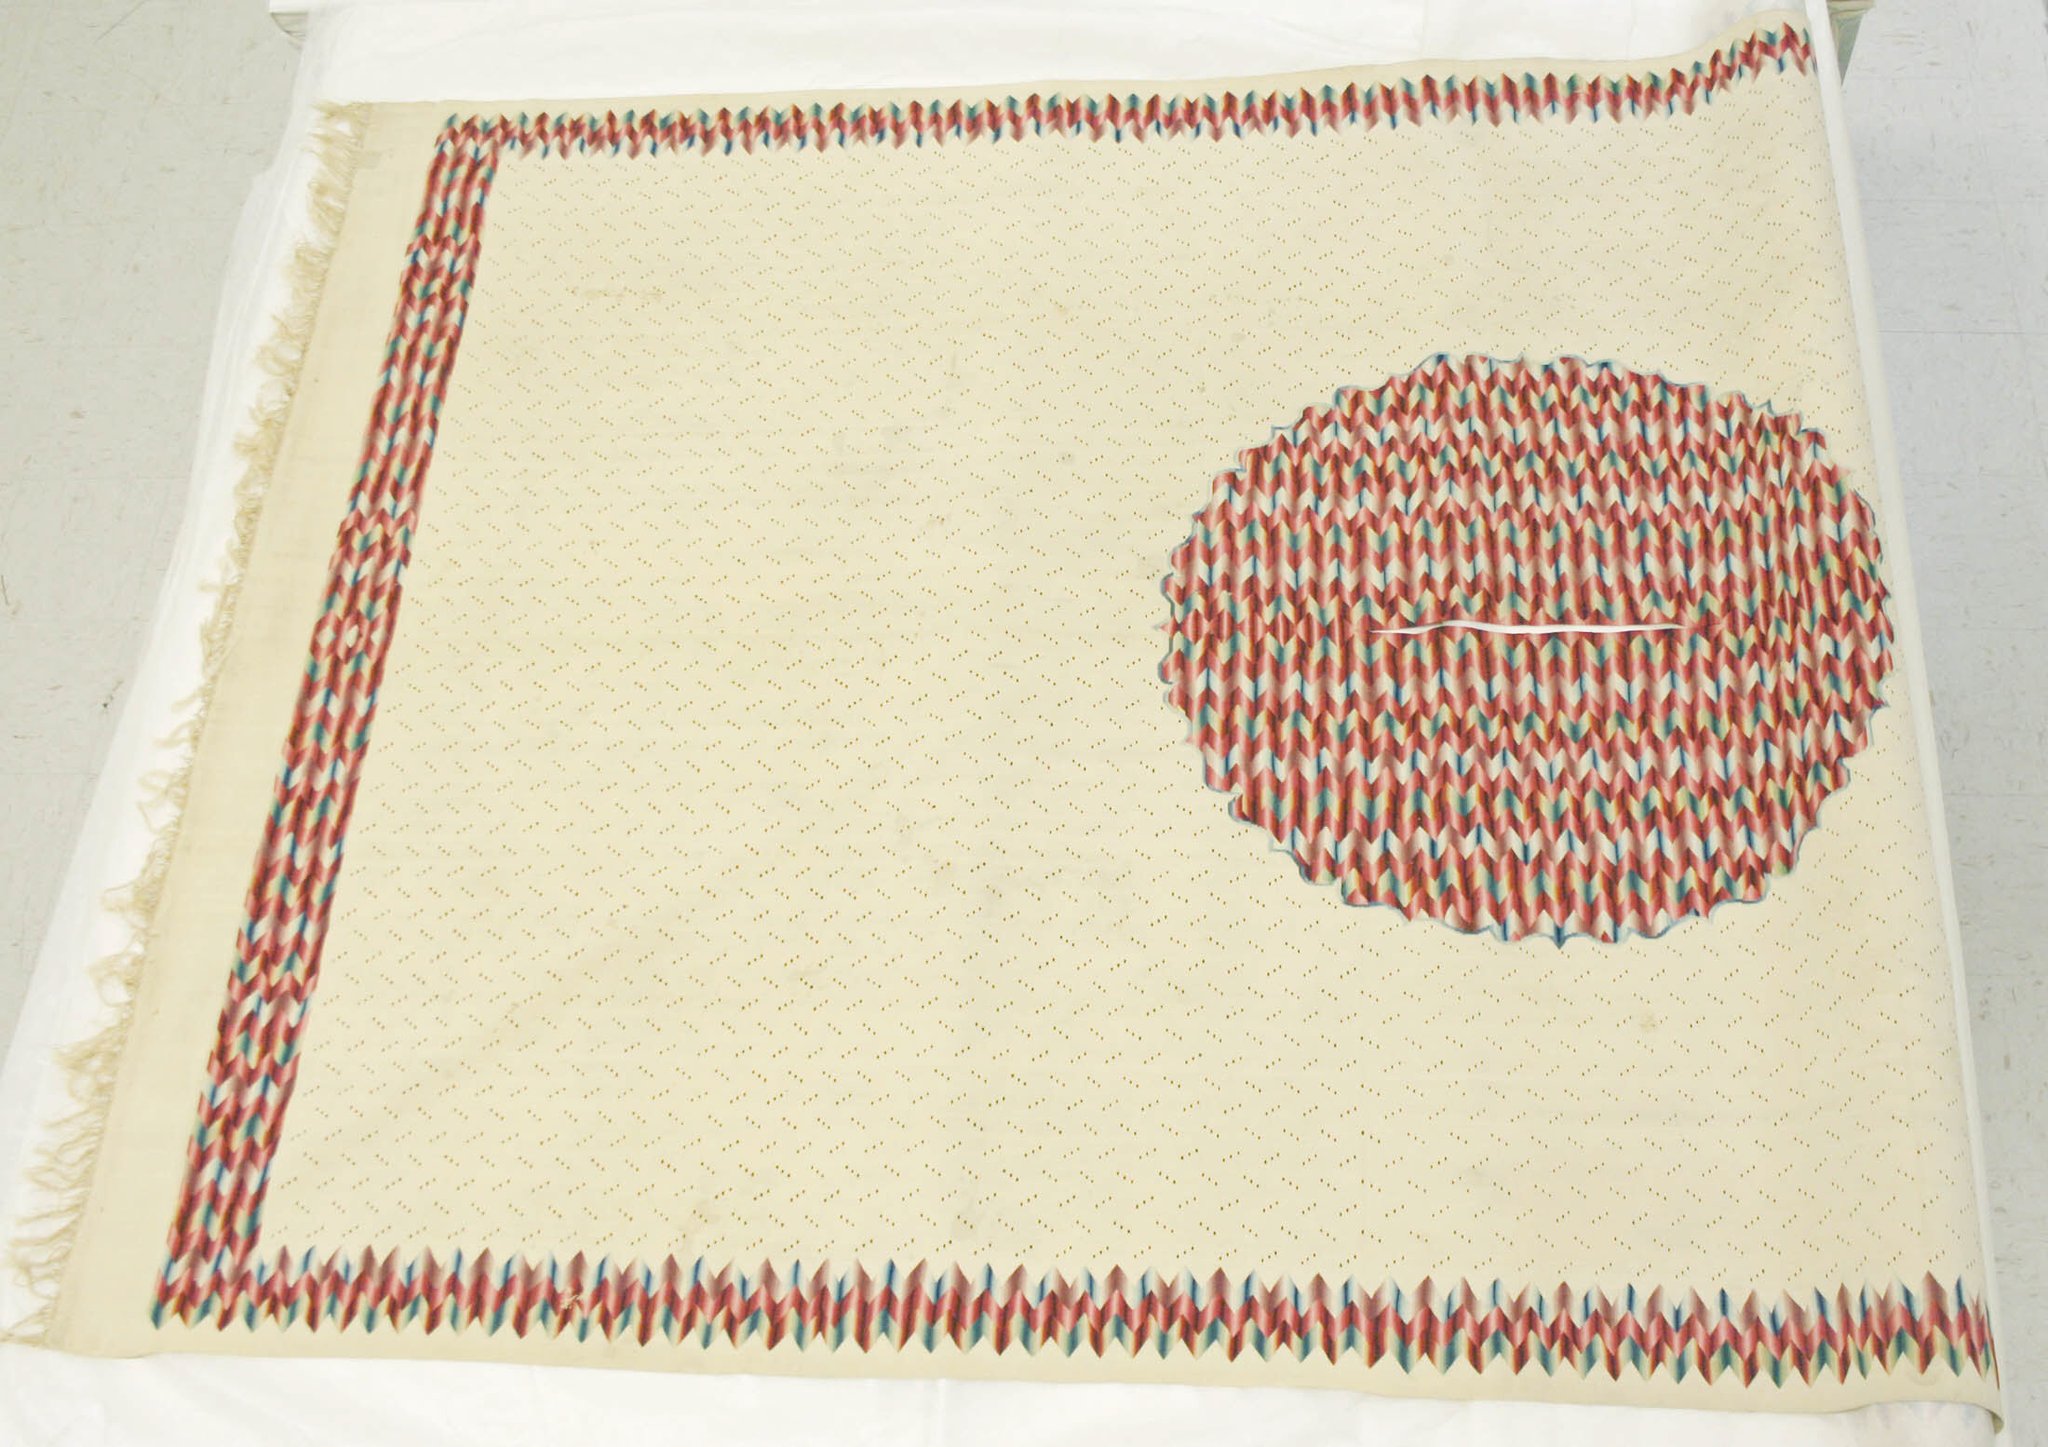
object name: poncho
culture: mexican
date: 1864-1880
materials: wool